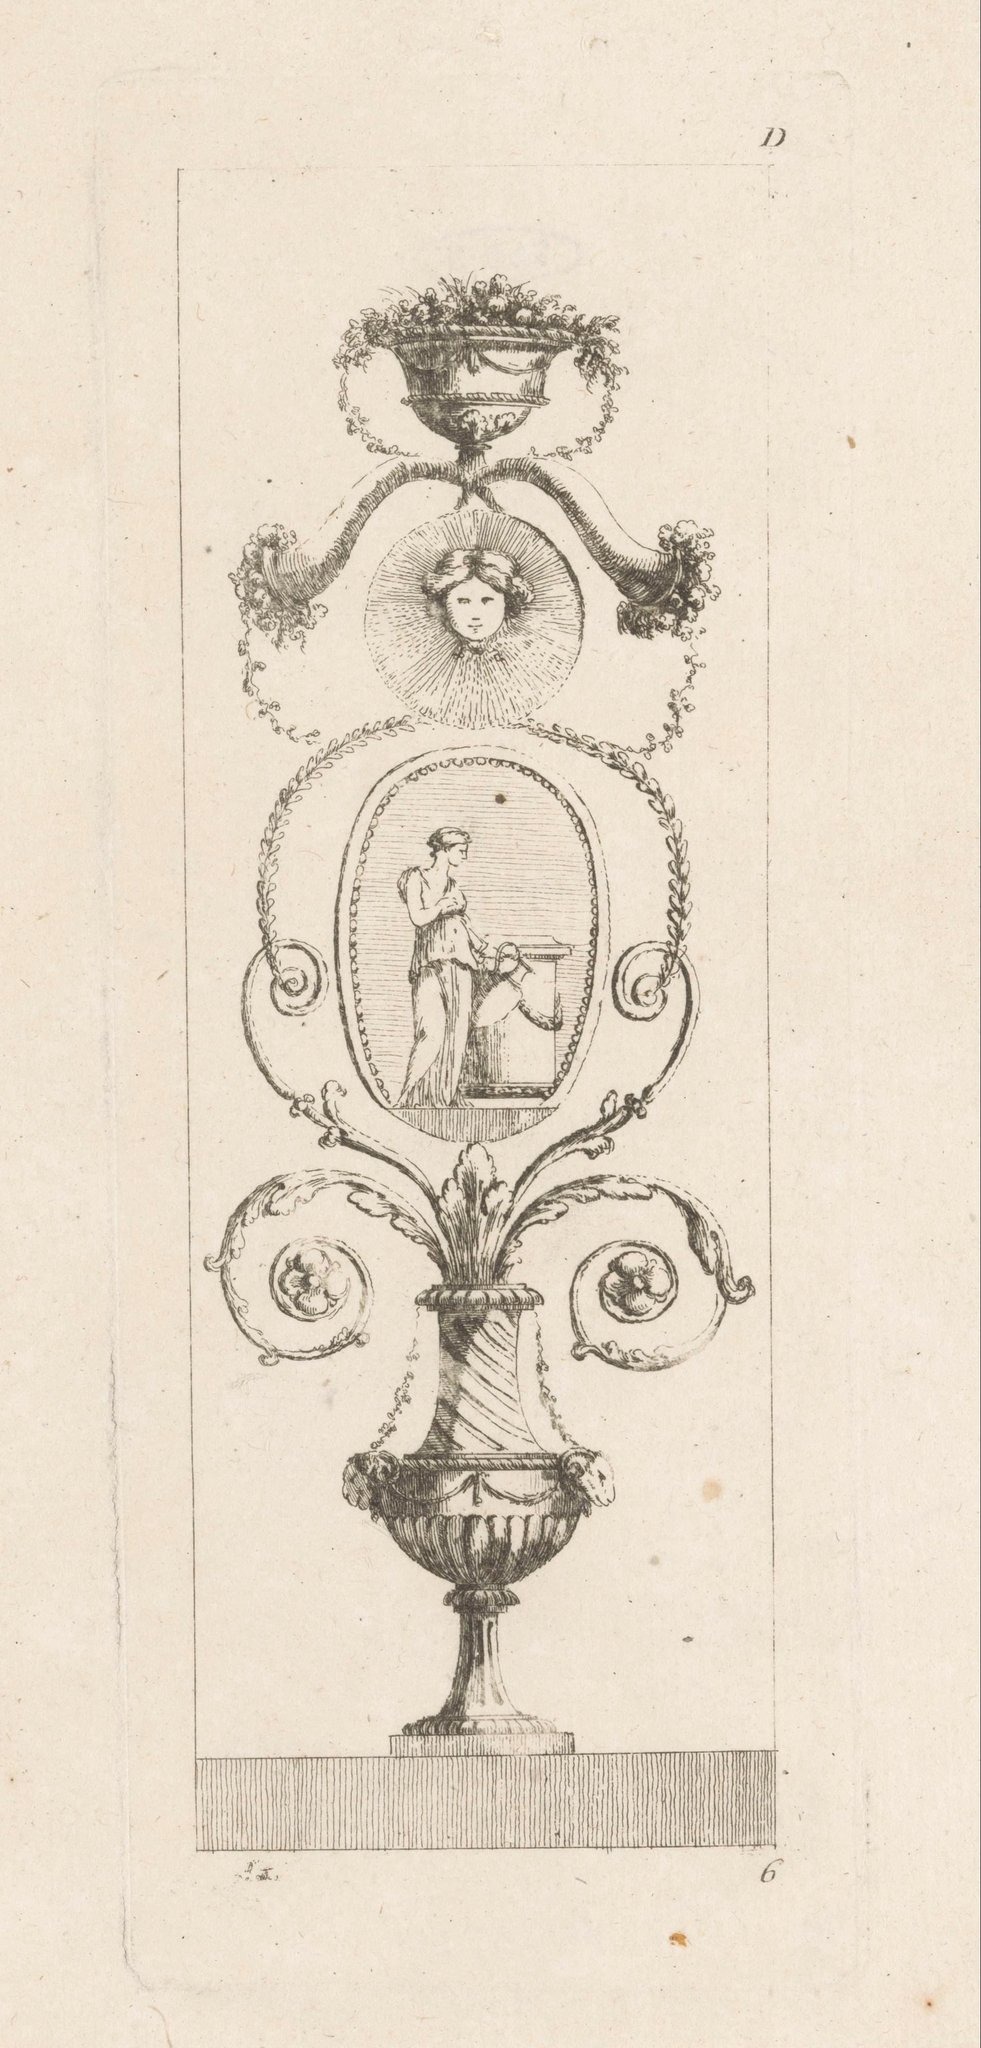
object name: ornament print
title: Vaas en medaillons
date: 1752-1782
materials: paper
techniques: etching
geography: paris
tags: 'cornucopia', horn of plenty, ornament ~ arabesque, ornament ~ medallion, vase ~ ornament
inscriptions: collector's mark: Lugt 2760, collector's mark: Lugt 2228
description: Een vaas waaruit arabesken ontspruiten met daarboven twee medaillons met figuren, aan de bovenzijde een vaas met bloemen en hoornen des overvloeds.